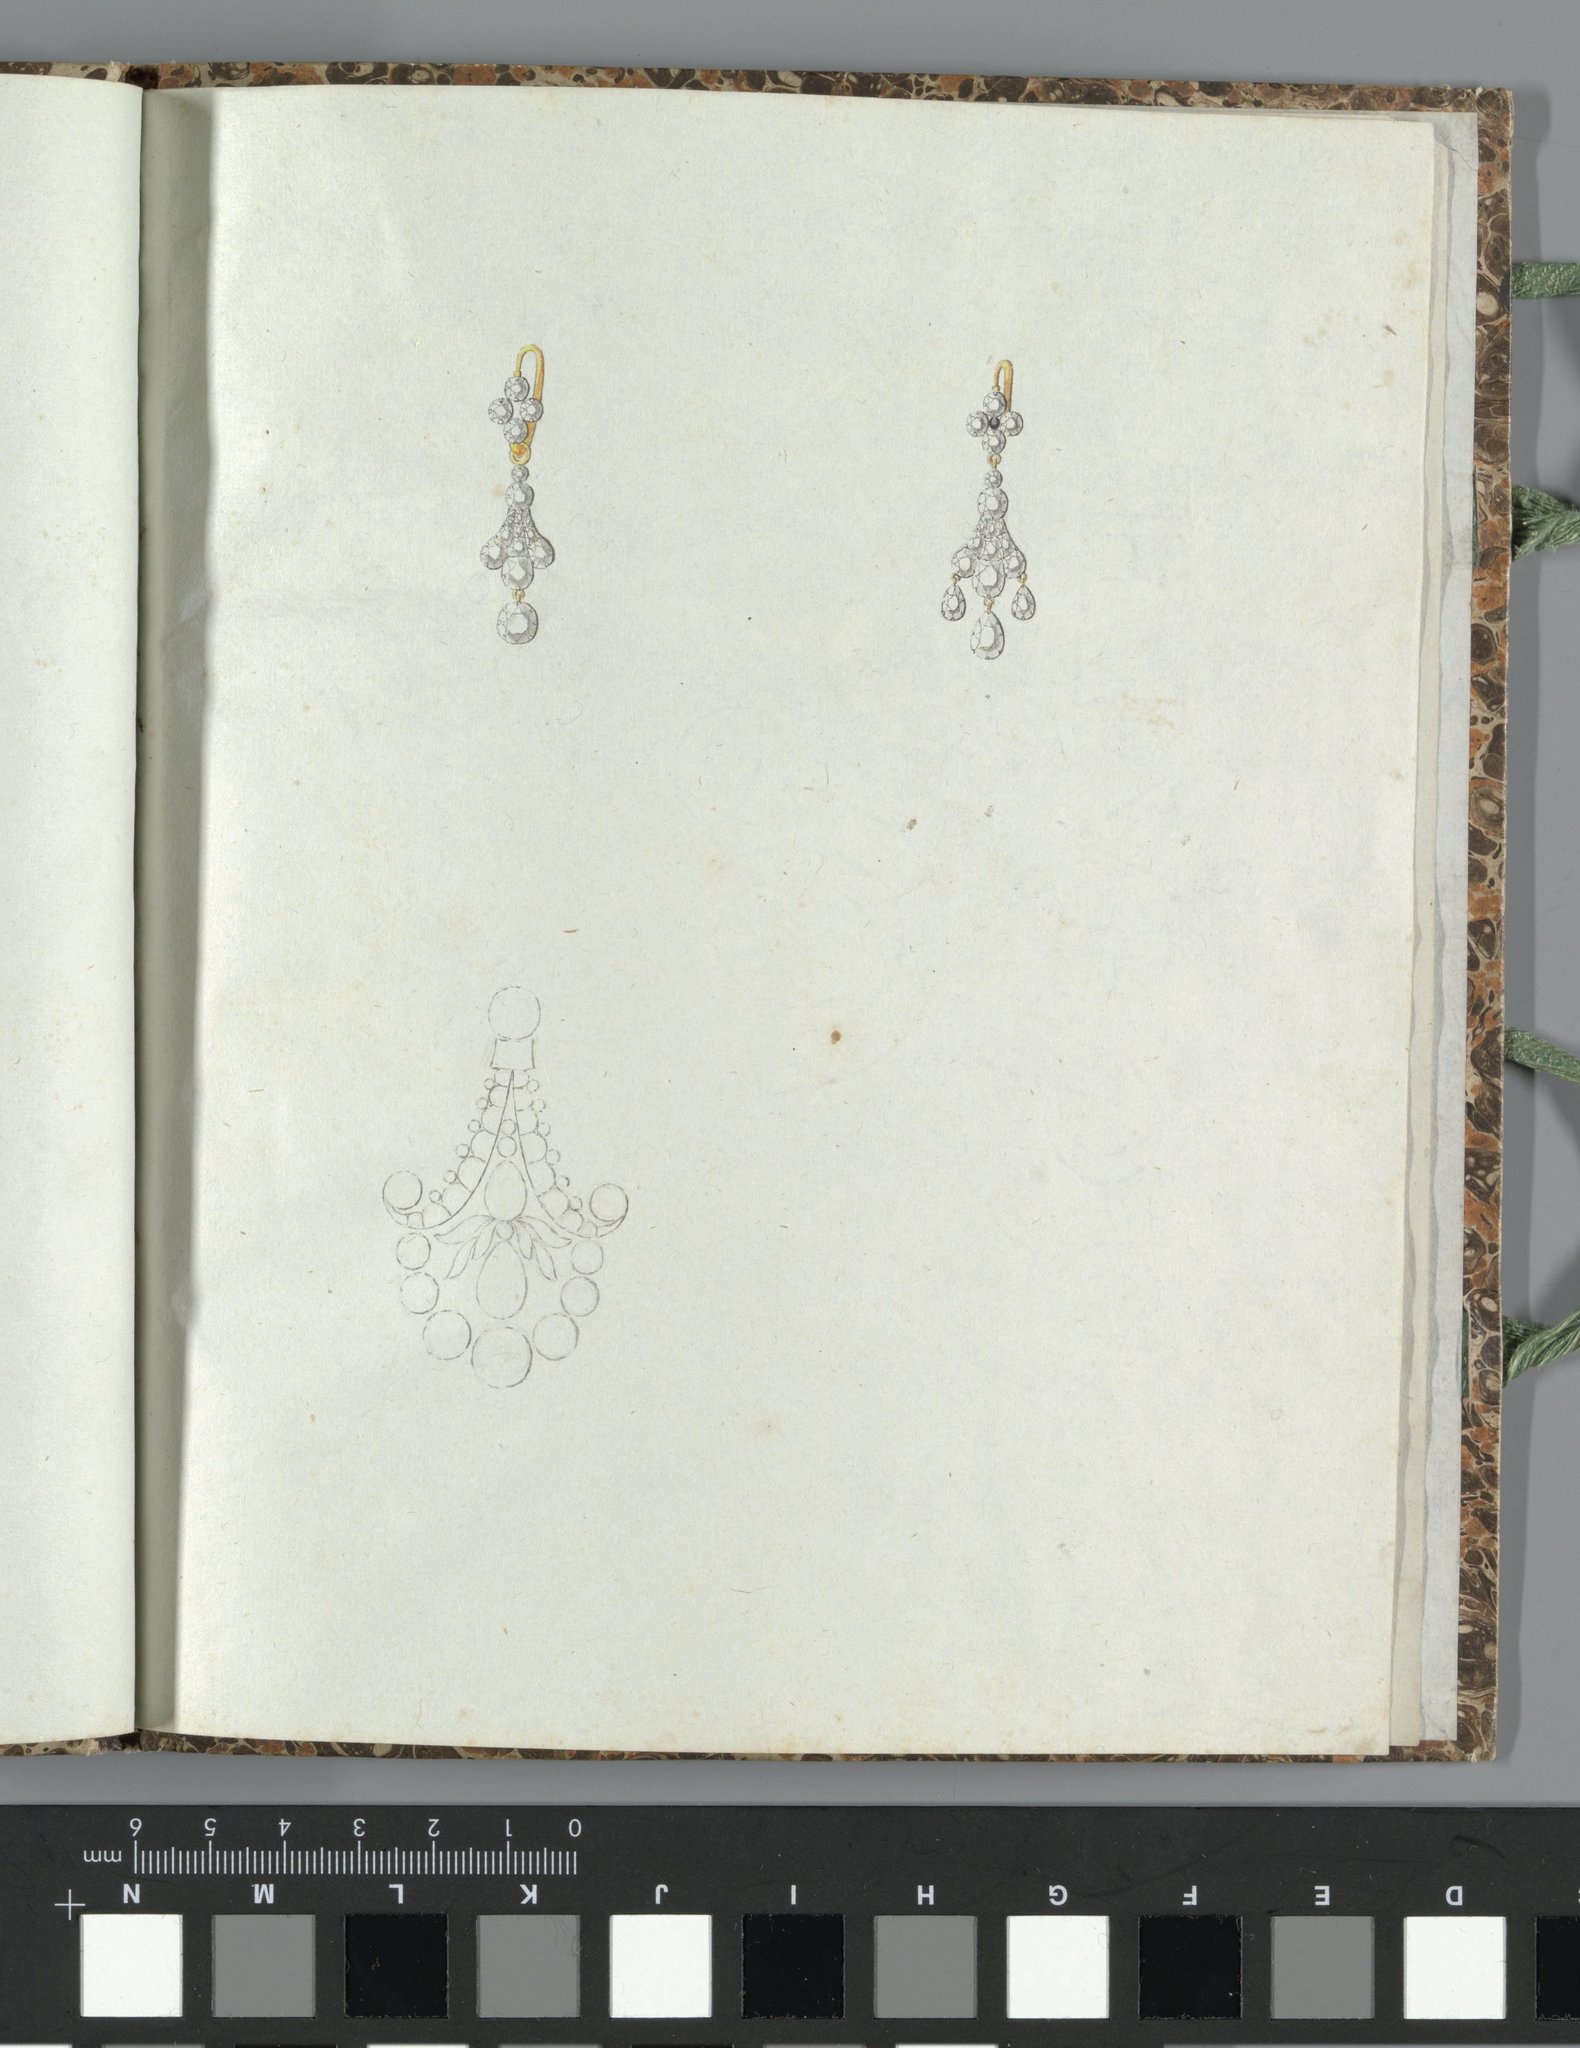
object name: watercolor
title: Twee oorhangers en een onuitgewerkte tekening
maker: carl friedrich bärthel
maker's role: draughtsman, jeweler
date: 1800-1810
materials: ink, paper, watercolor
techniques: brush, pen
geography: augsburg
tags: ornaments, jewels, ear-rings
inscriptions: watermark